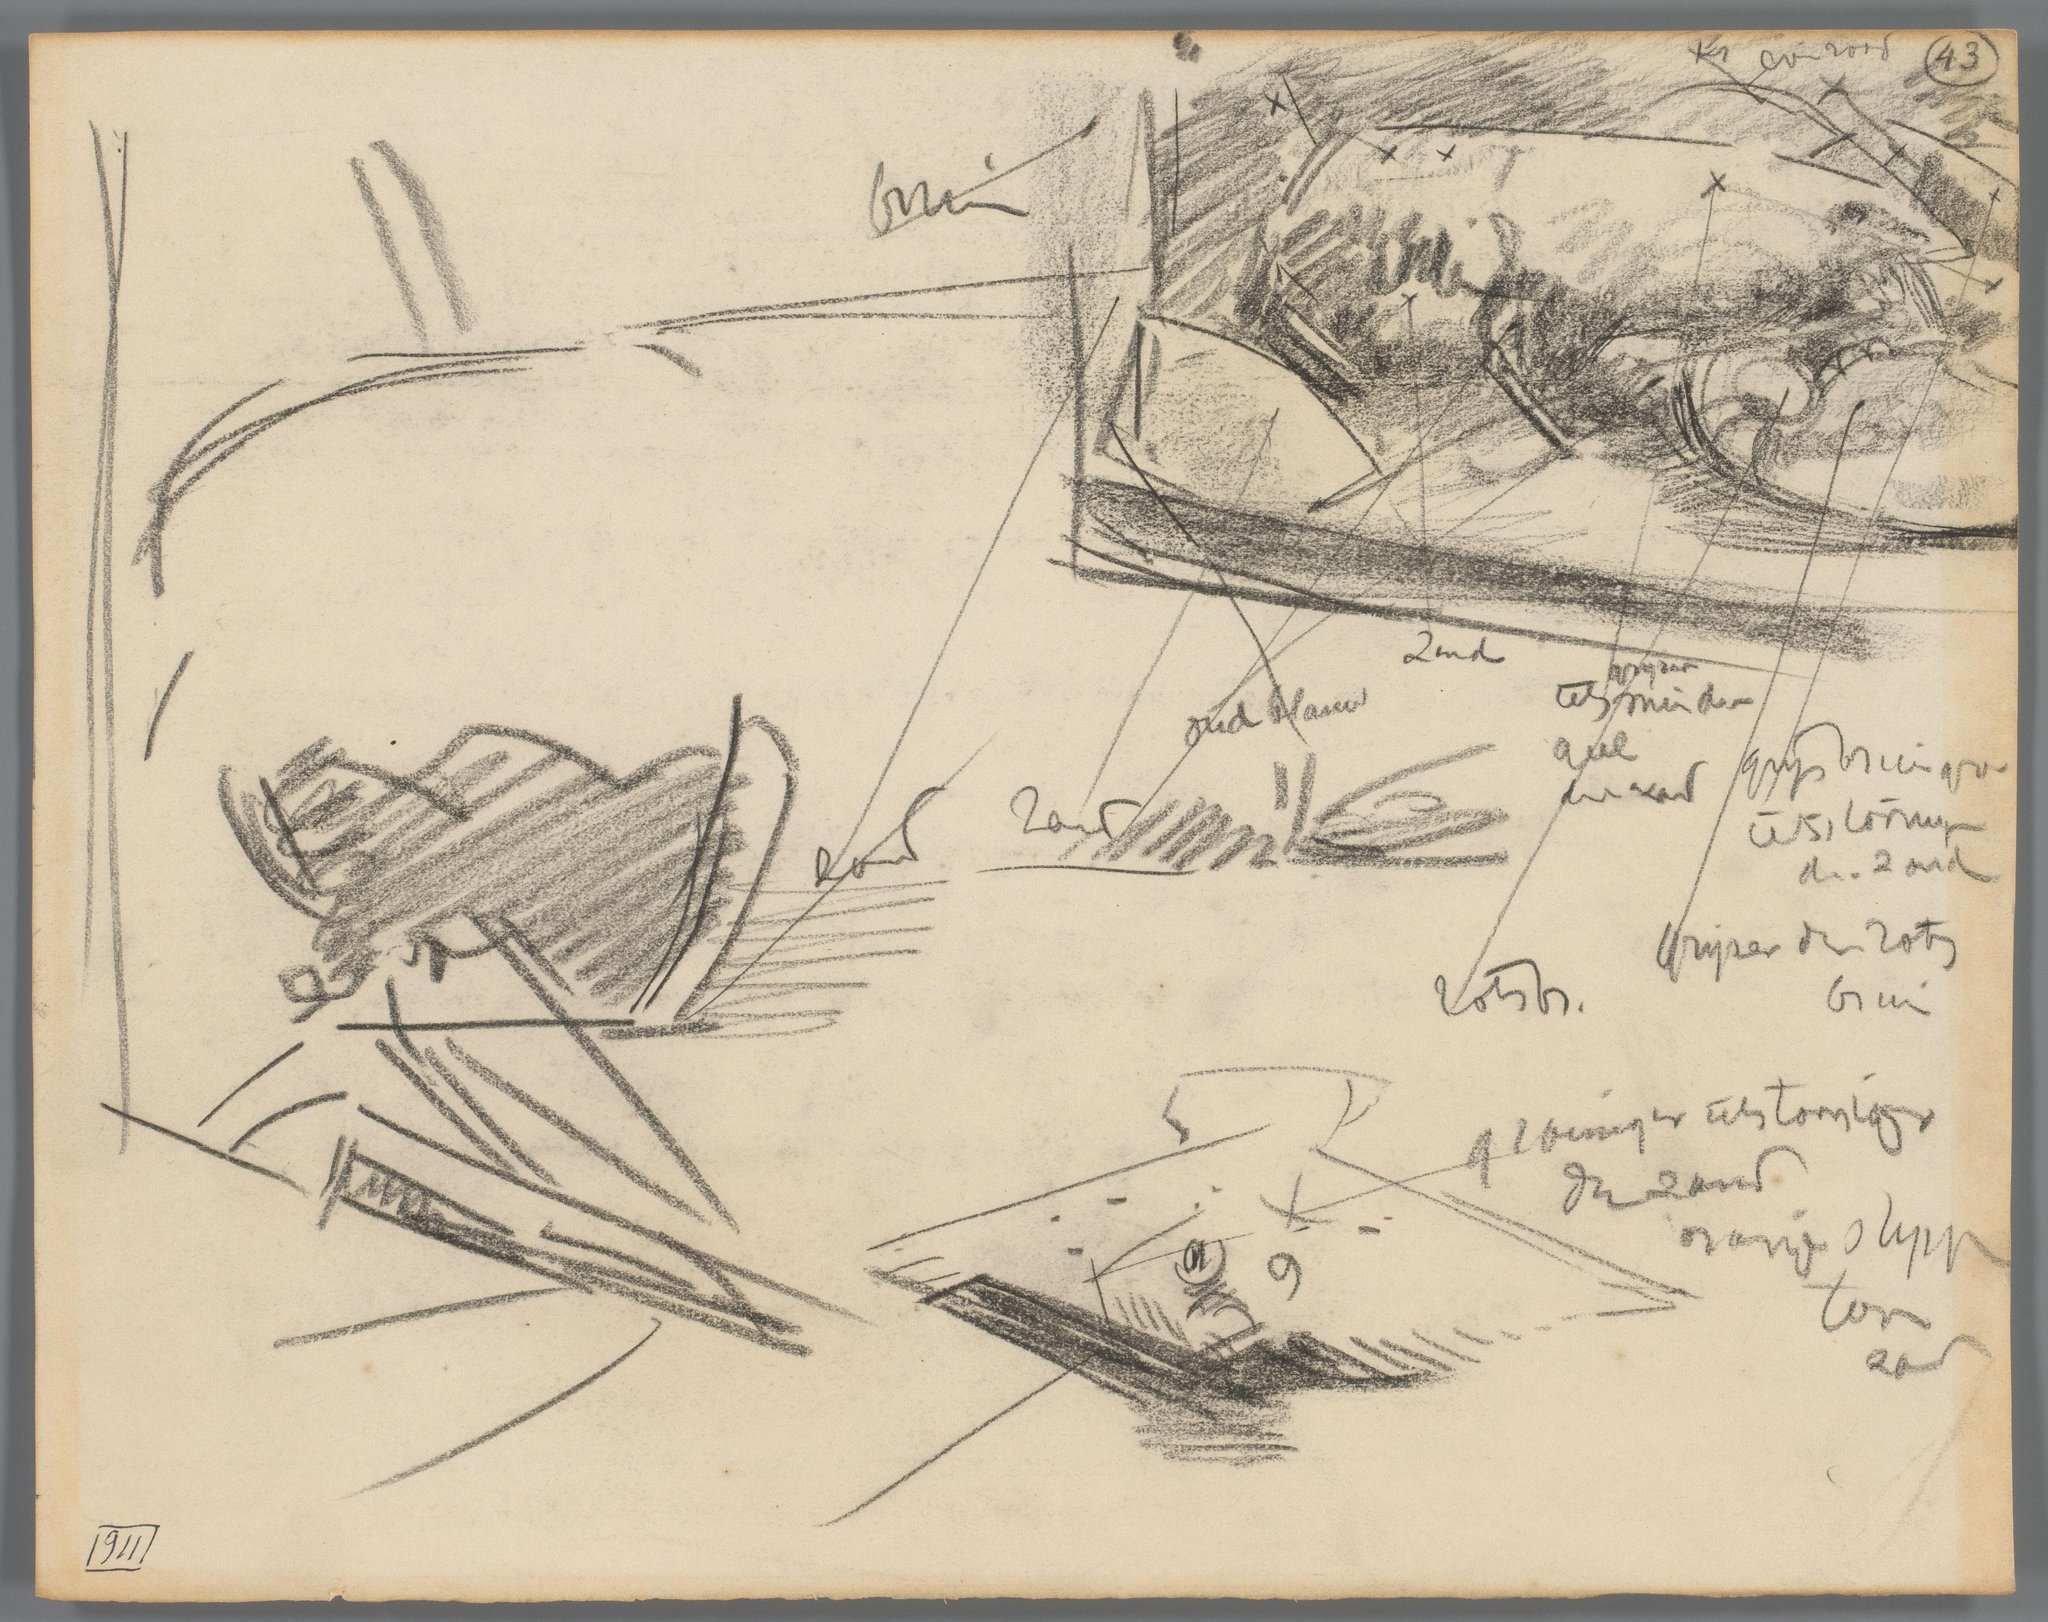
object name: drawing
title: Studies van lichaamsdelen van een kreeft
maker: gerrit willem dijsselhof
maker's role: designer, draughtsman, print maker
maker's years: 1866-1924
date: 1876-1924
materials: chalk, paper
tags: crustaceans: lobster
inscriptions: number: ‘911’, number: ‘43’